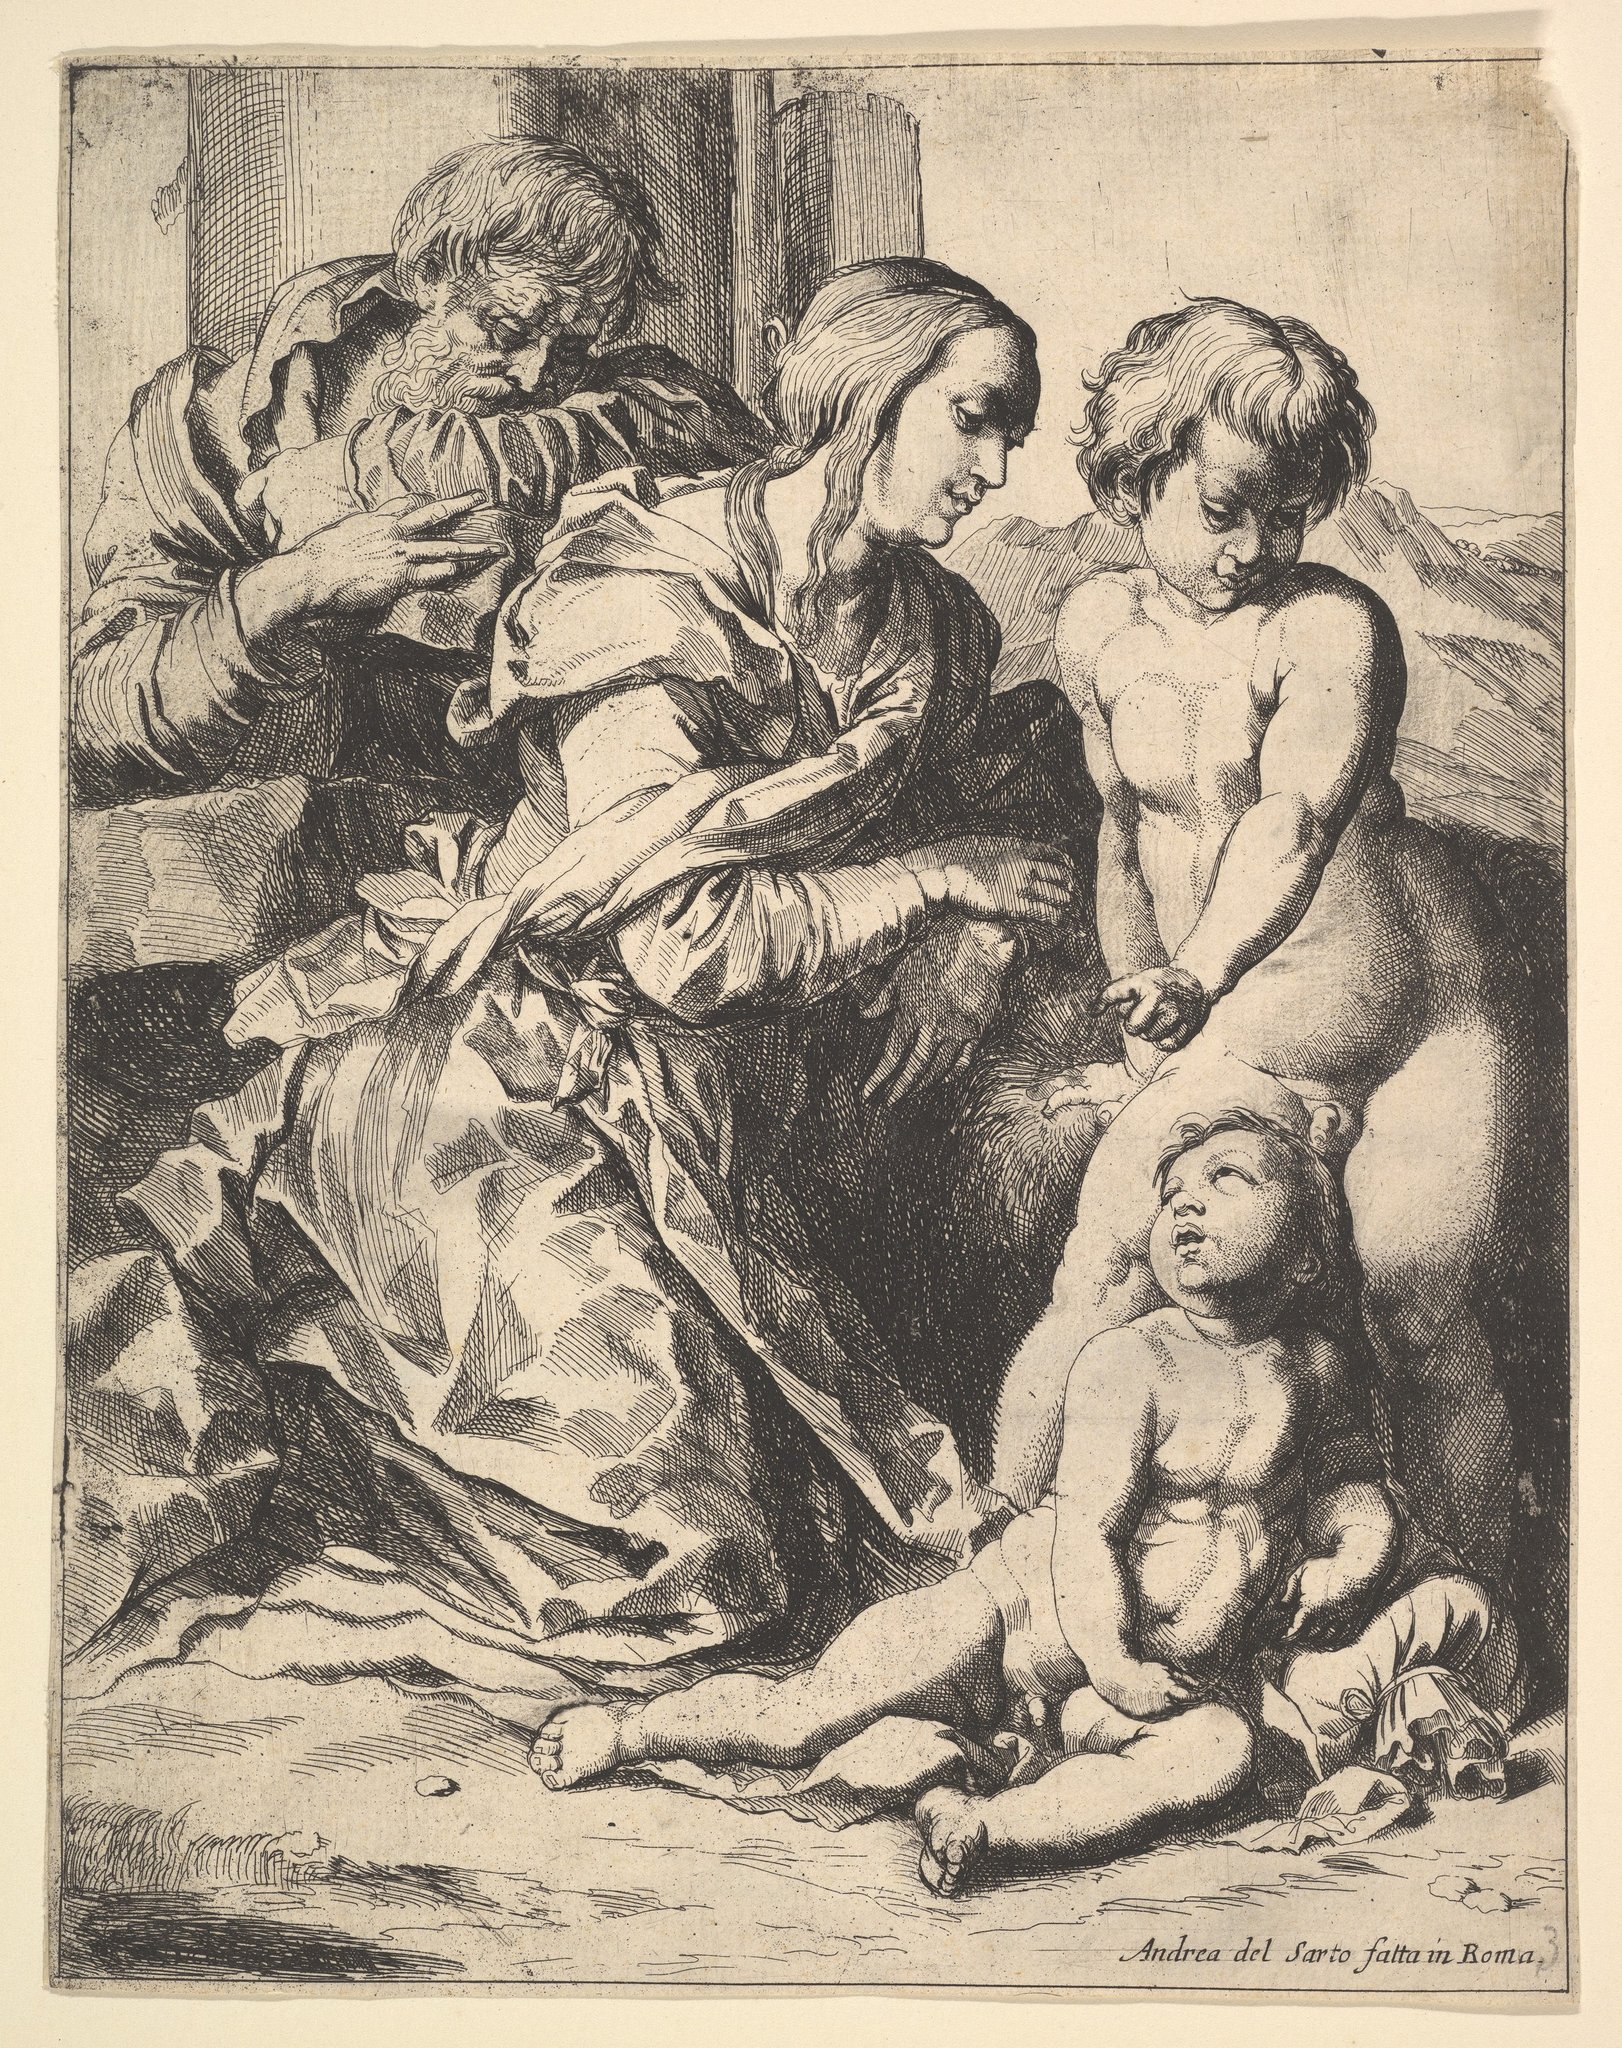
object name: print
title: Virgin kneeling before Christ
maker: pierre brebiette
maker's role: artist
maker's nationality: french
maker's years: 1598-1642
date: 1610-1642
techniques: etching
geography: france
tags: christ,virgin mary